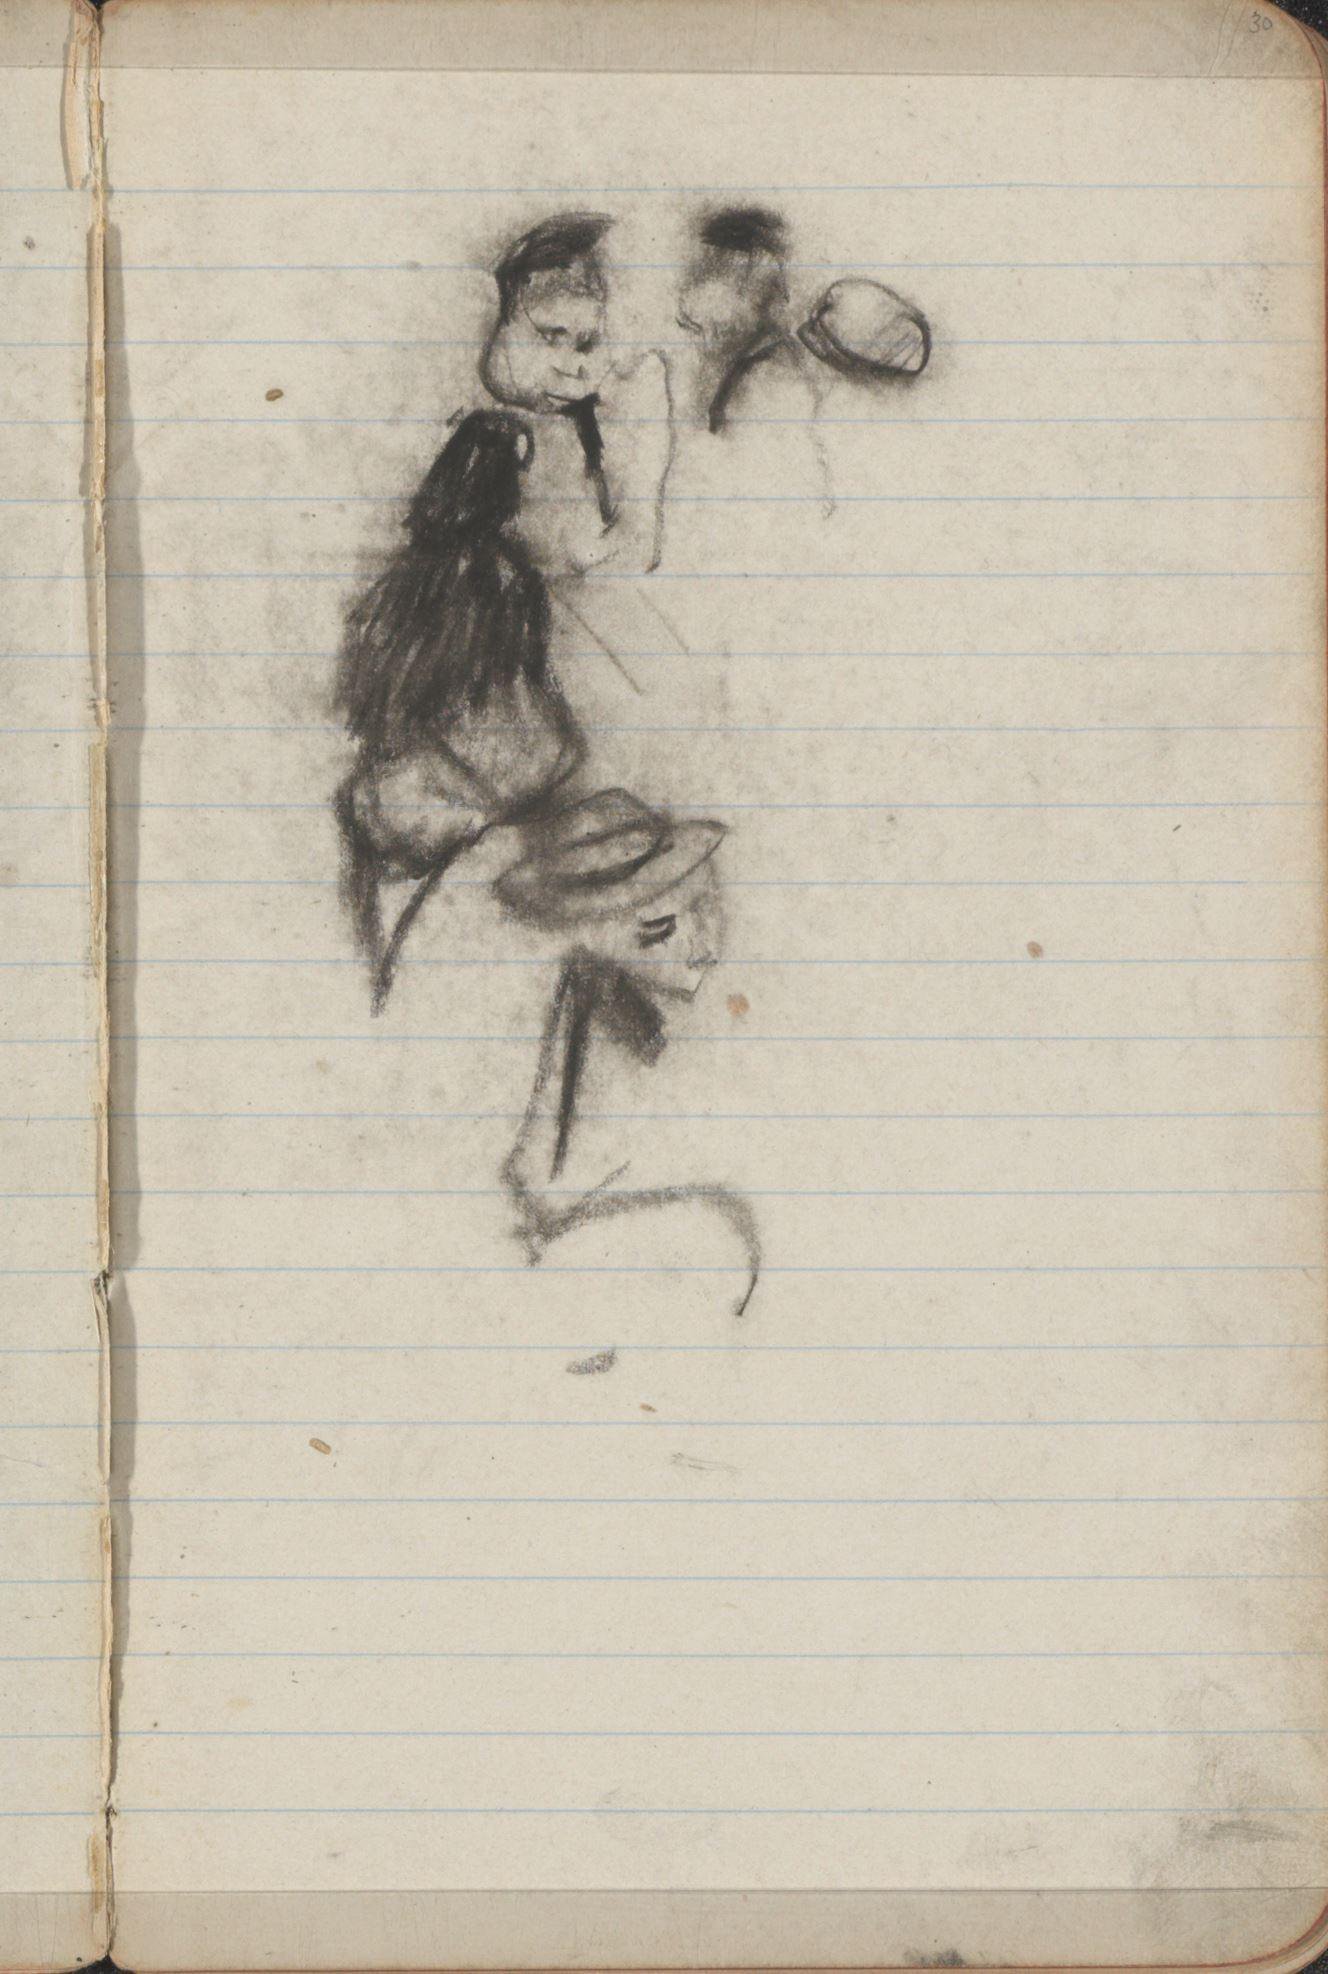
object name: sketchbook leaf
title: Figuurstudies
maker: george hendrik breitner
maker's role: draughtsman, painter, print maker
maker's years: 1857-1923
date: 1893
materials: chalk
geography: amsterdam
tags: adult woman, adult man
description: Pagina 30 uit een schetsboek met 38 bladen.